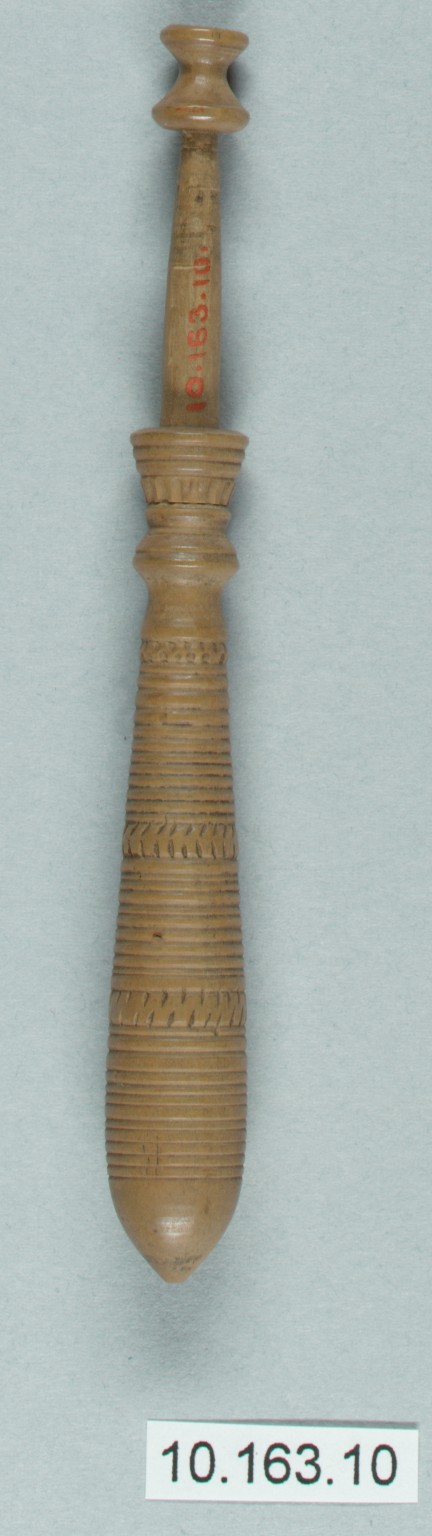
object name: bobbin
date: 1801-1900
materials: wood